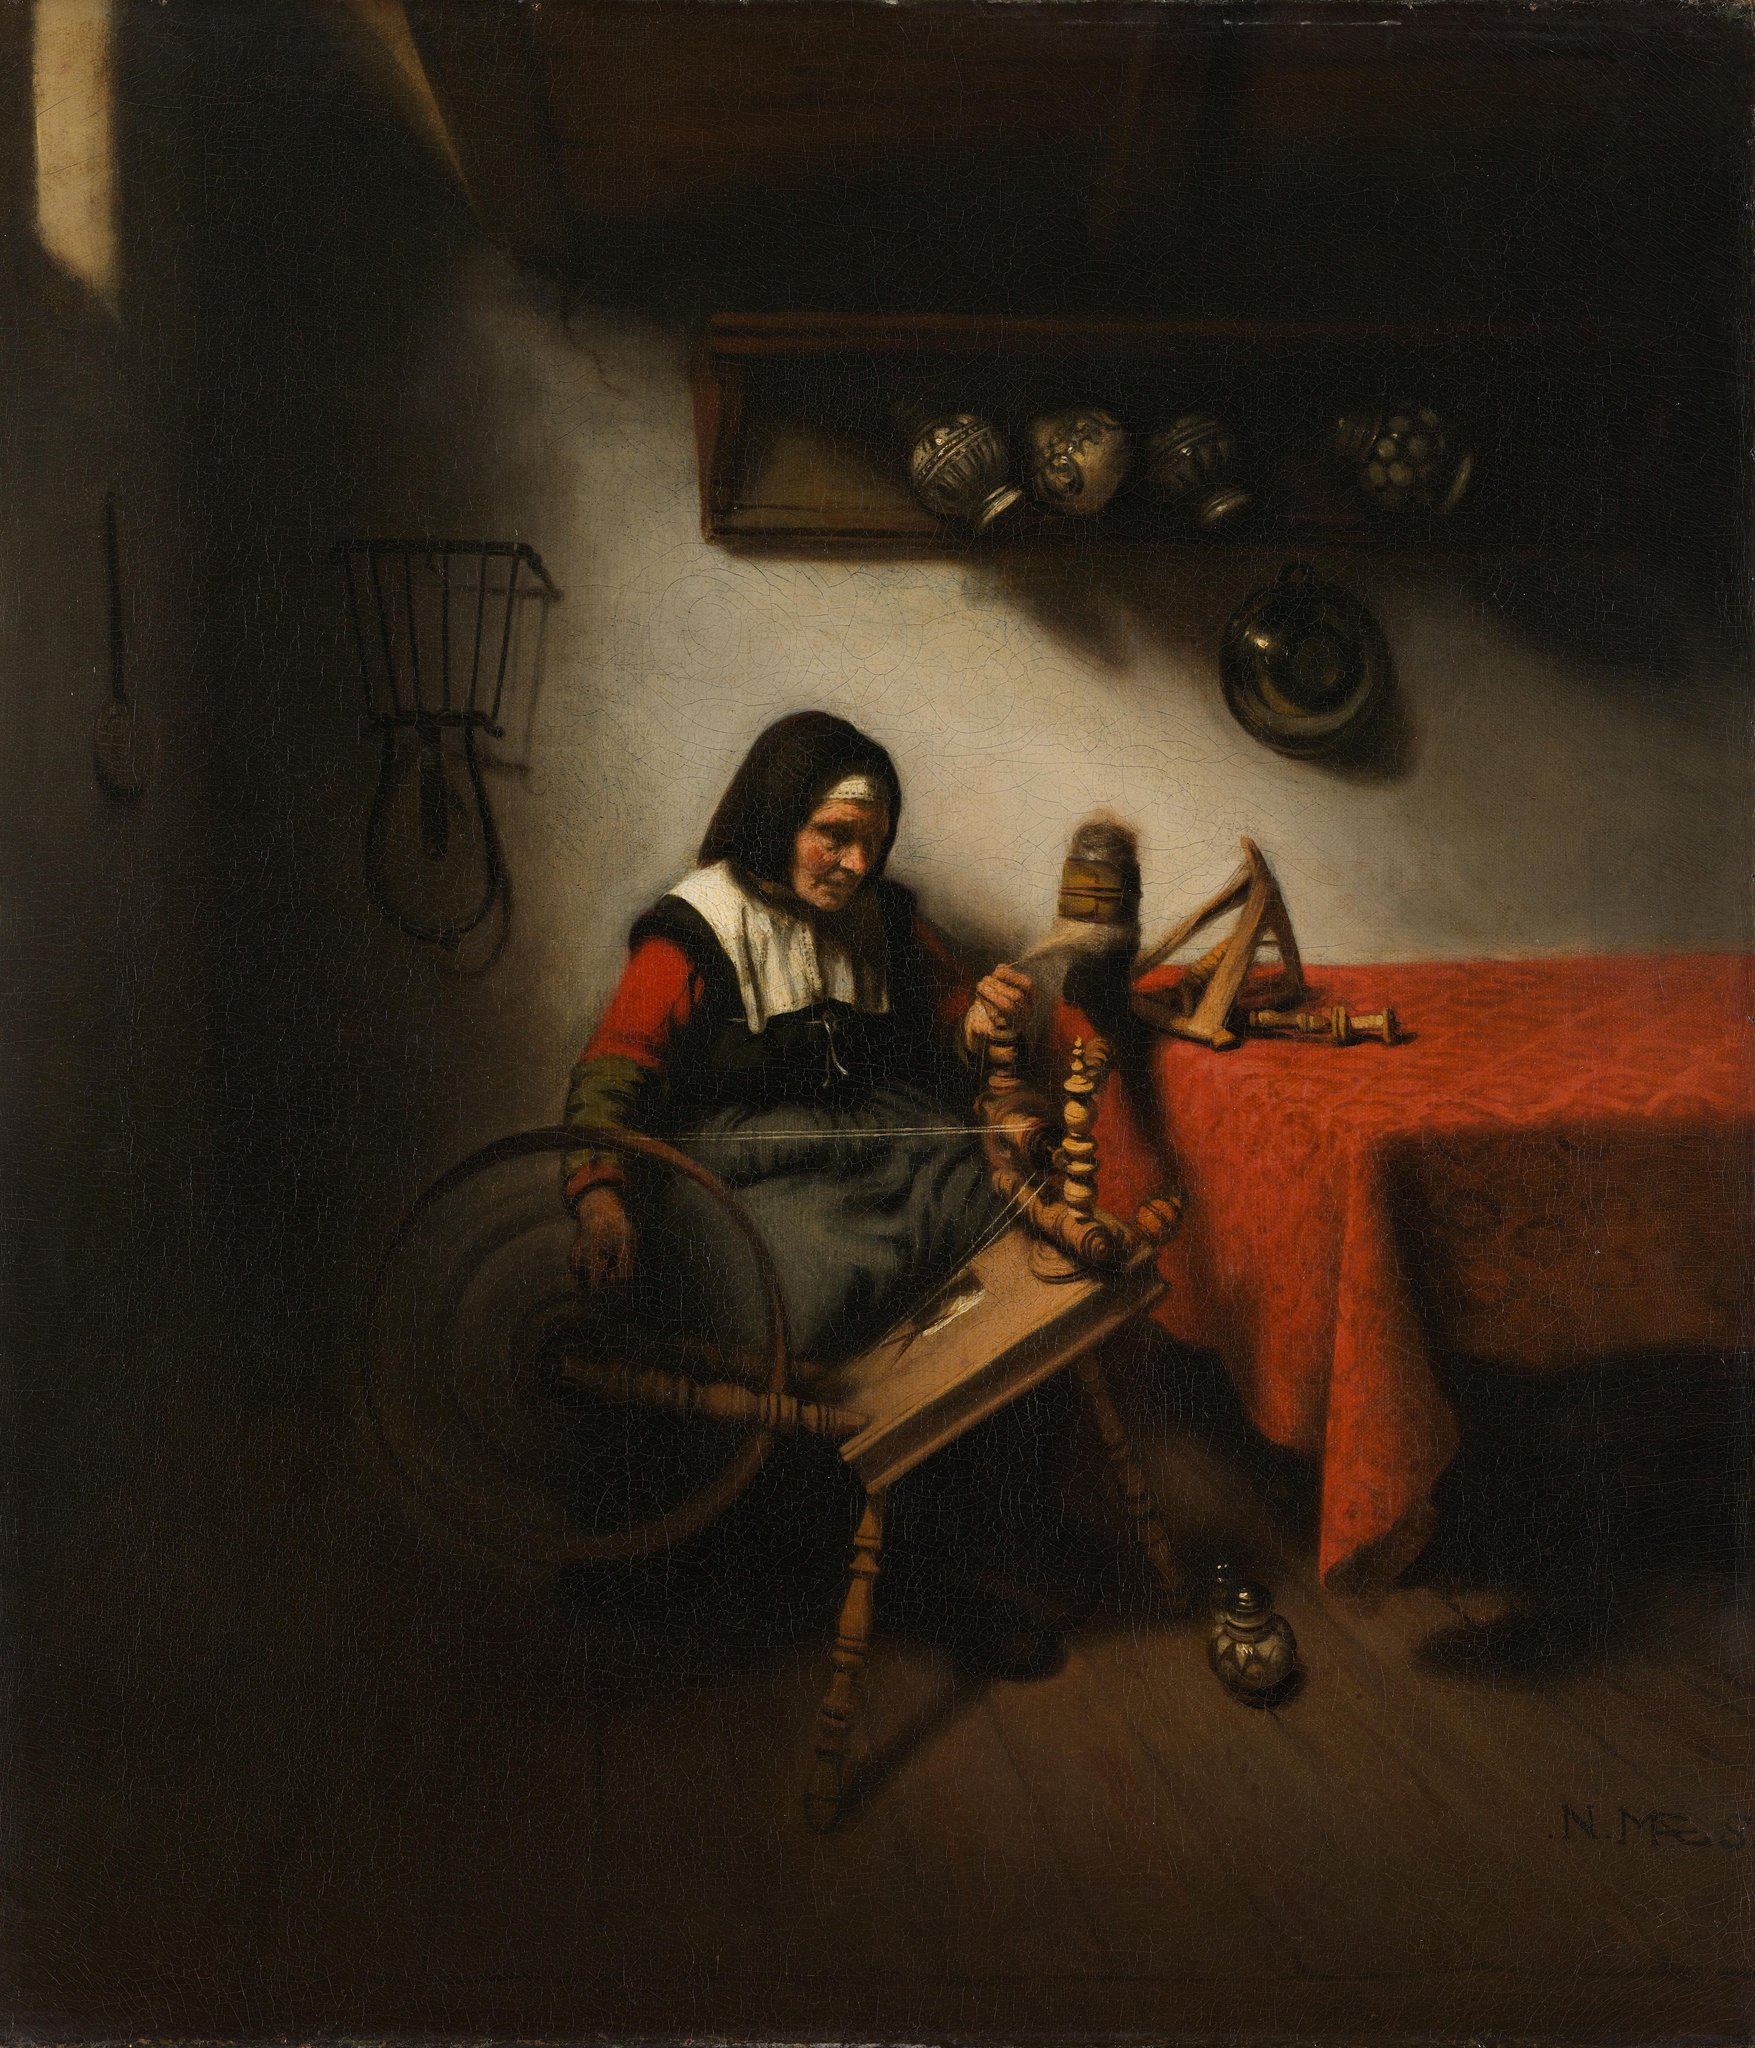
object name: painting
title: Old Woman Spinning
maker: nicolaes maes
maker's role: draughtsman, painter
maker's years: 1634-1693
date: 1650-1660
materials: canvas, oil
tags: spinning-wheel, container of ceramics: jar, jug, pot, vase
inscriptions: signature: ‘N. MAES’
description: Van Rembrandt kennen we geen schilderijen met huiselijke taferelen. Zijn leerling Nicolaes Maes schilderde daarentegen veel deugdzame vrouwen die bezig zijn in huis. Hier spint een oude vrouw wol. Zij heeft zich teruggetrokken in de hoek van een kamer, waar het laatste restje daglicht valt. Deze wijze van belichten nam Maes over van zijn leermeester.